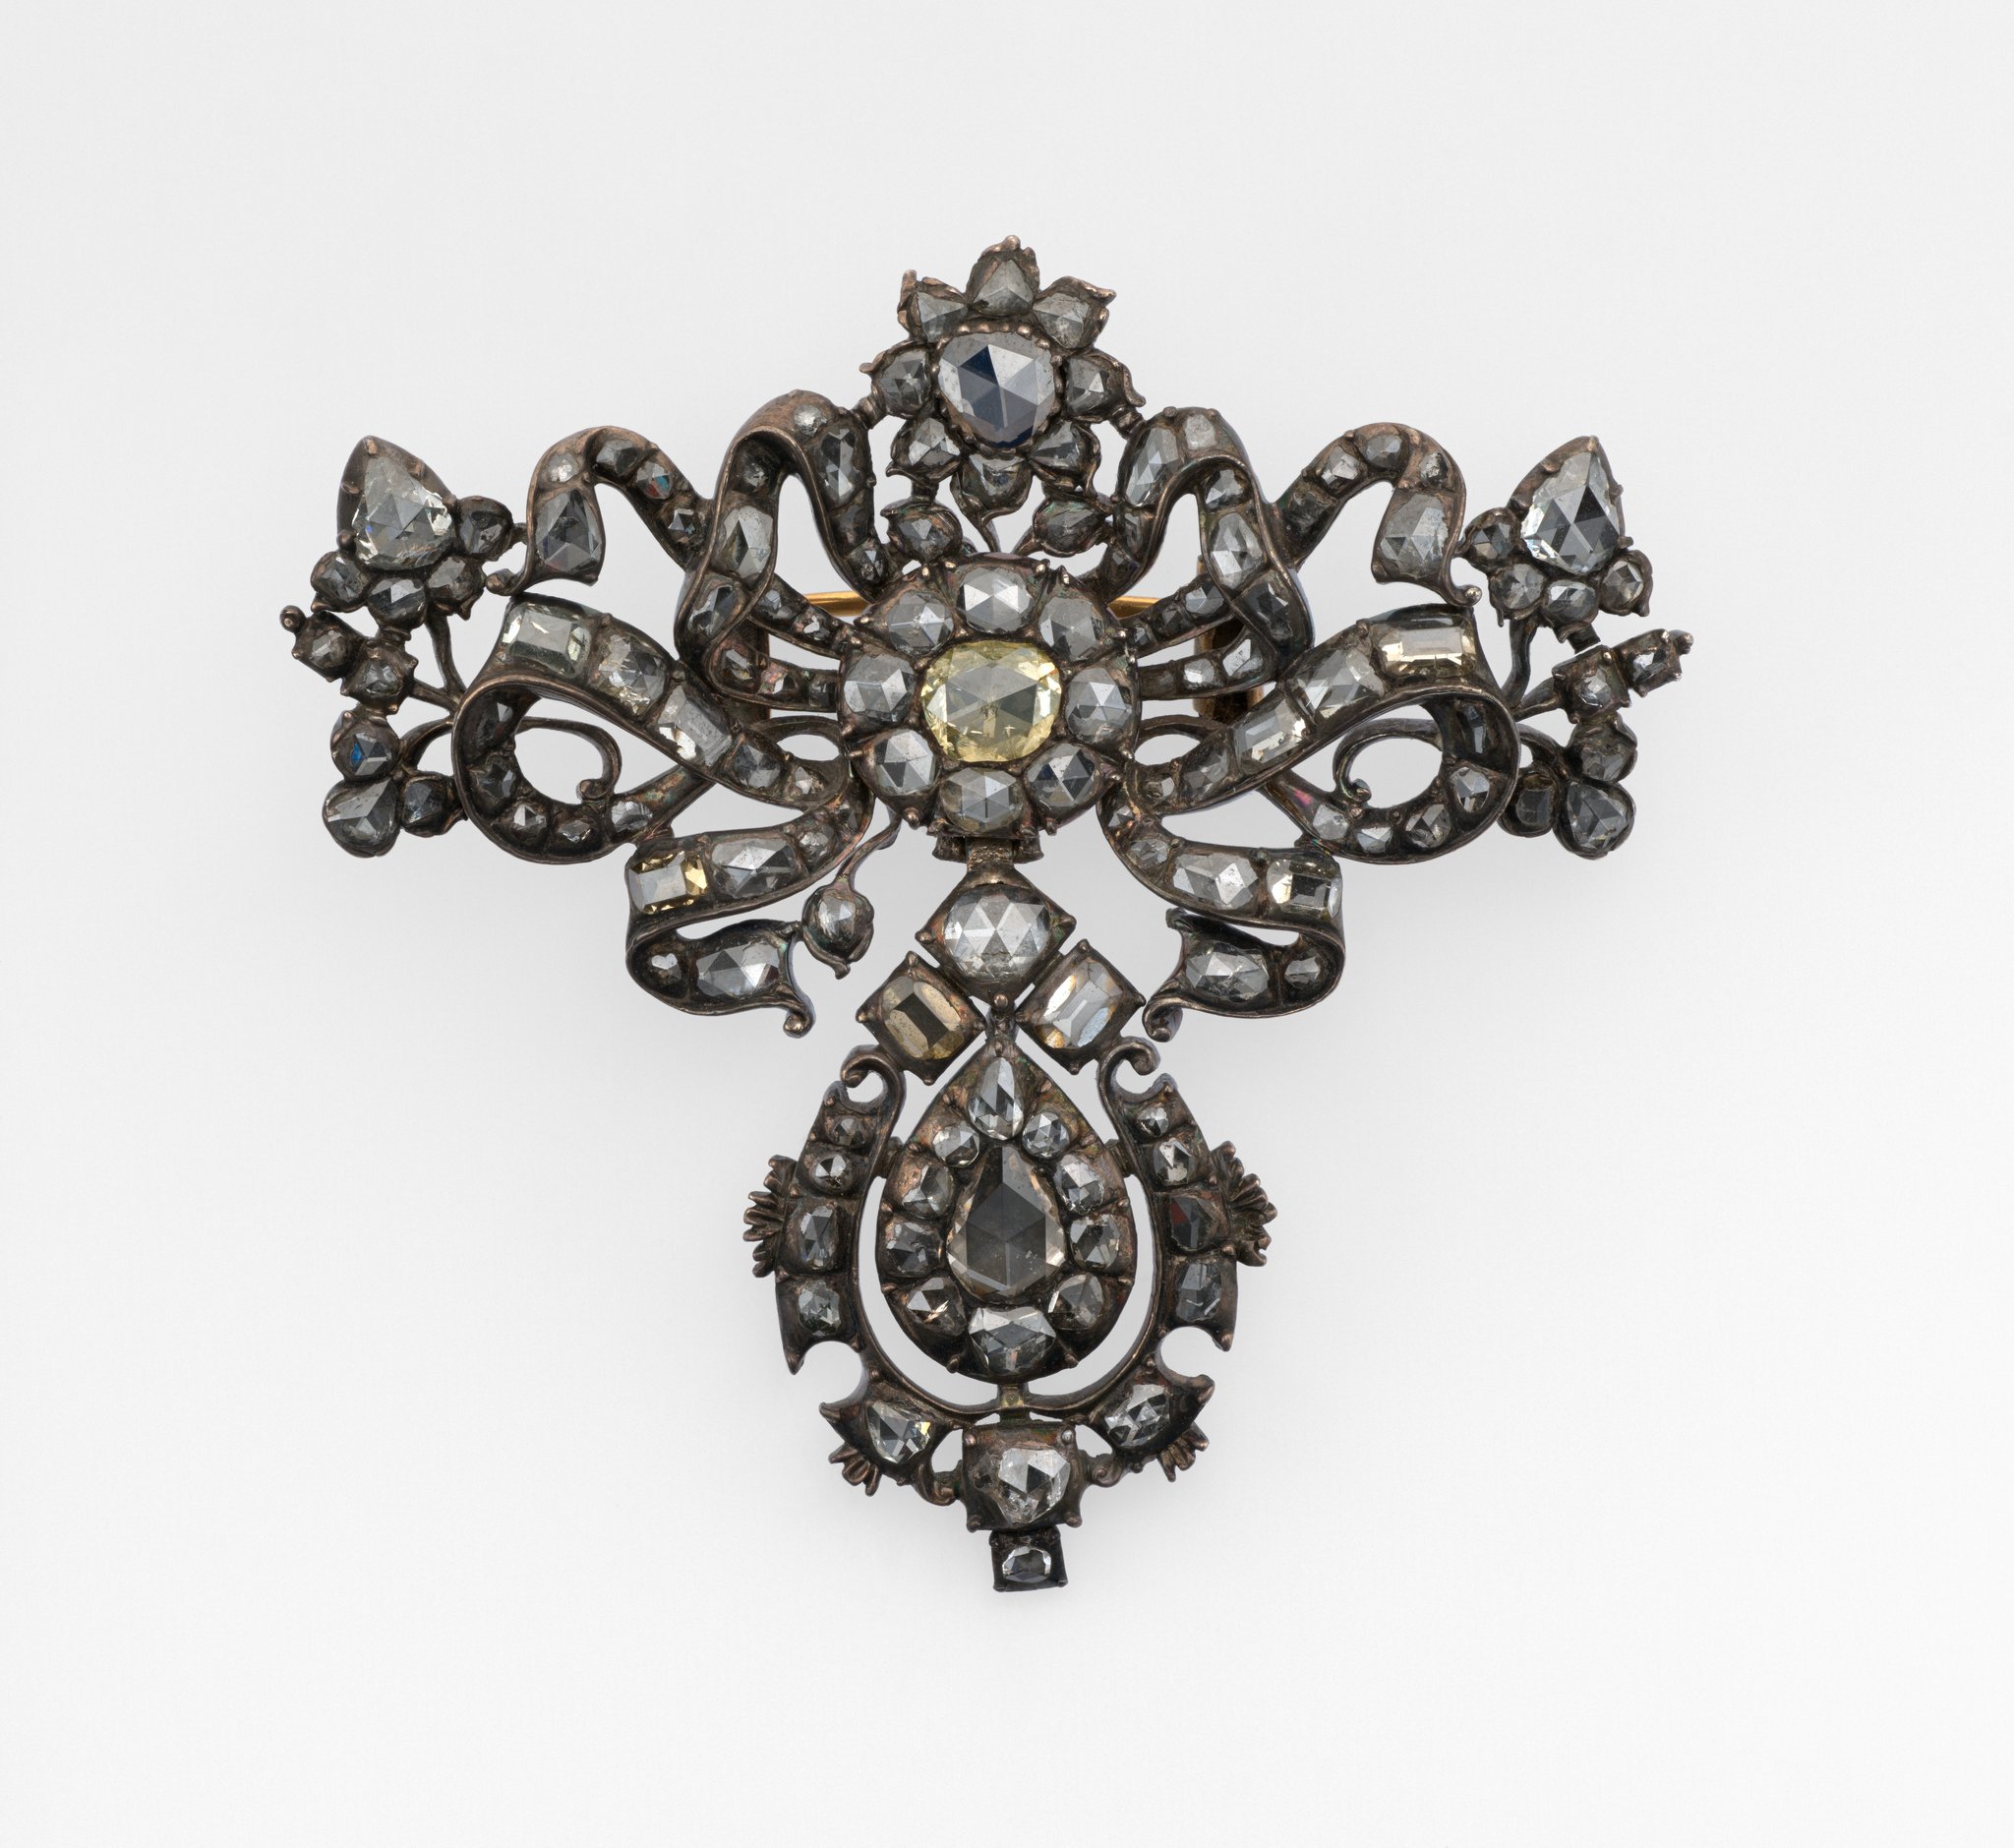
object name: brooch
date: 1701-1800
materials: diamond, silver